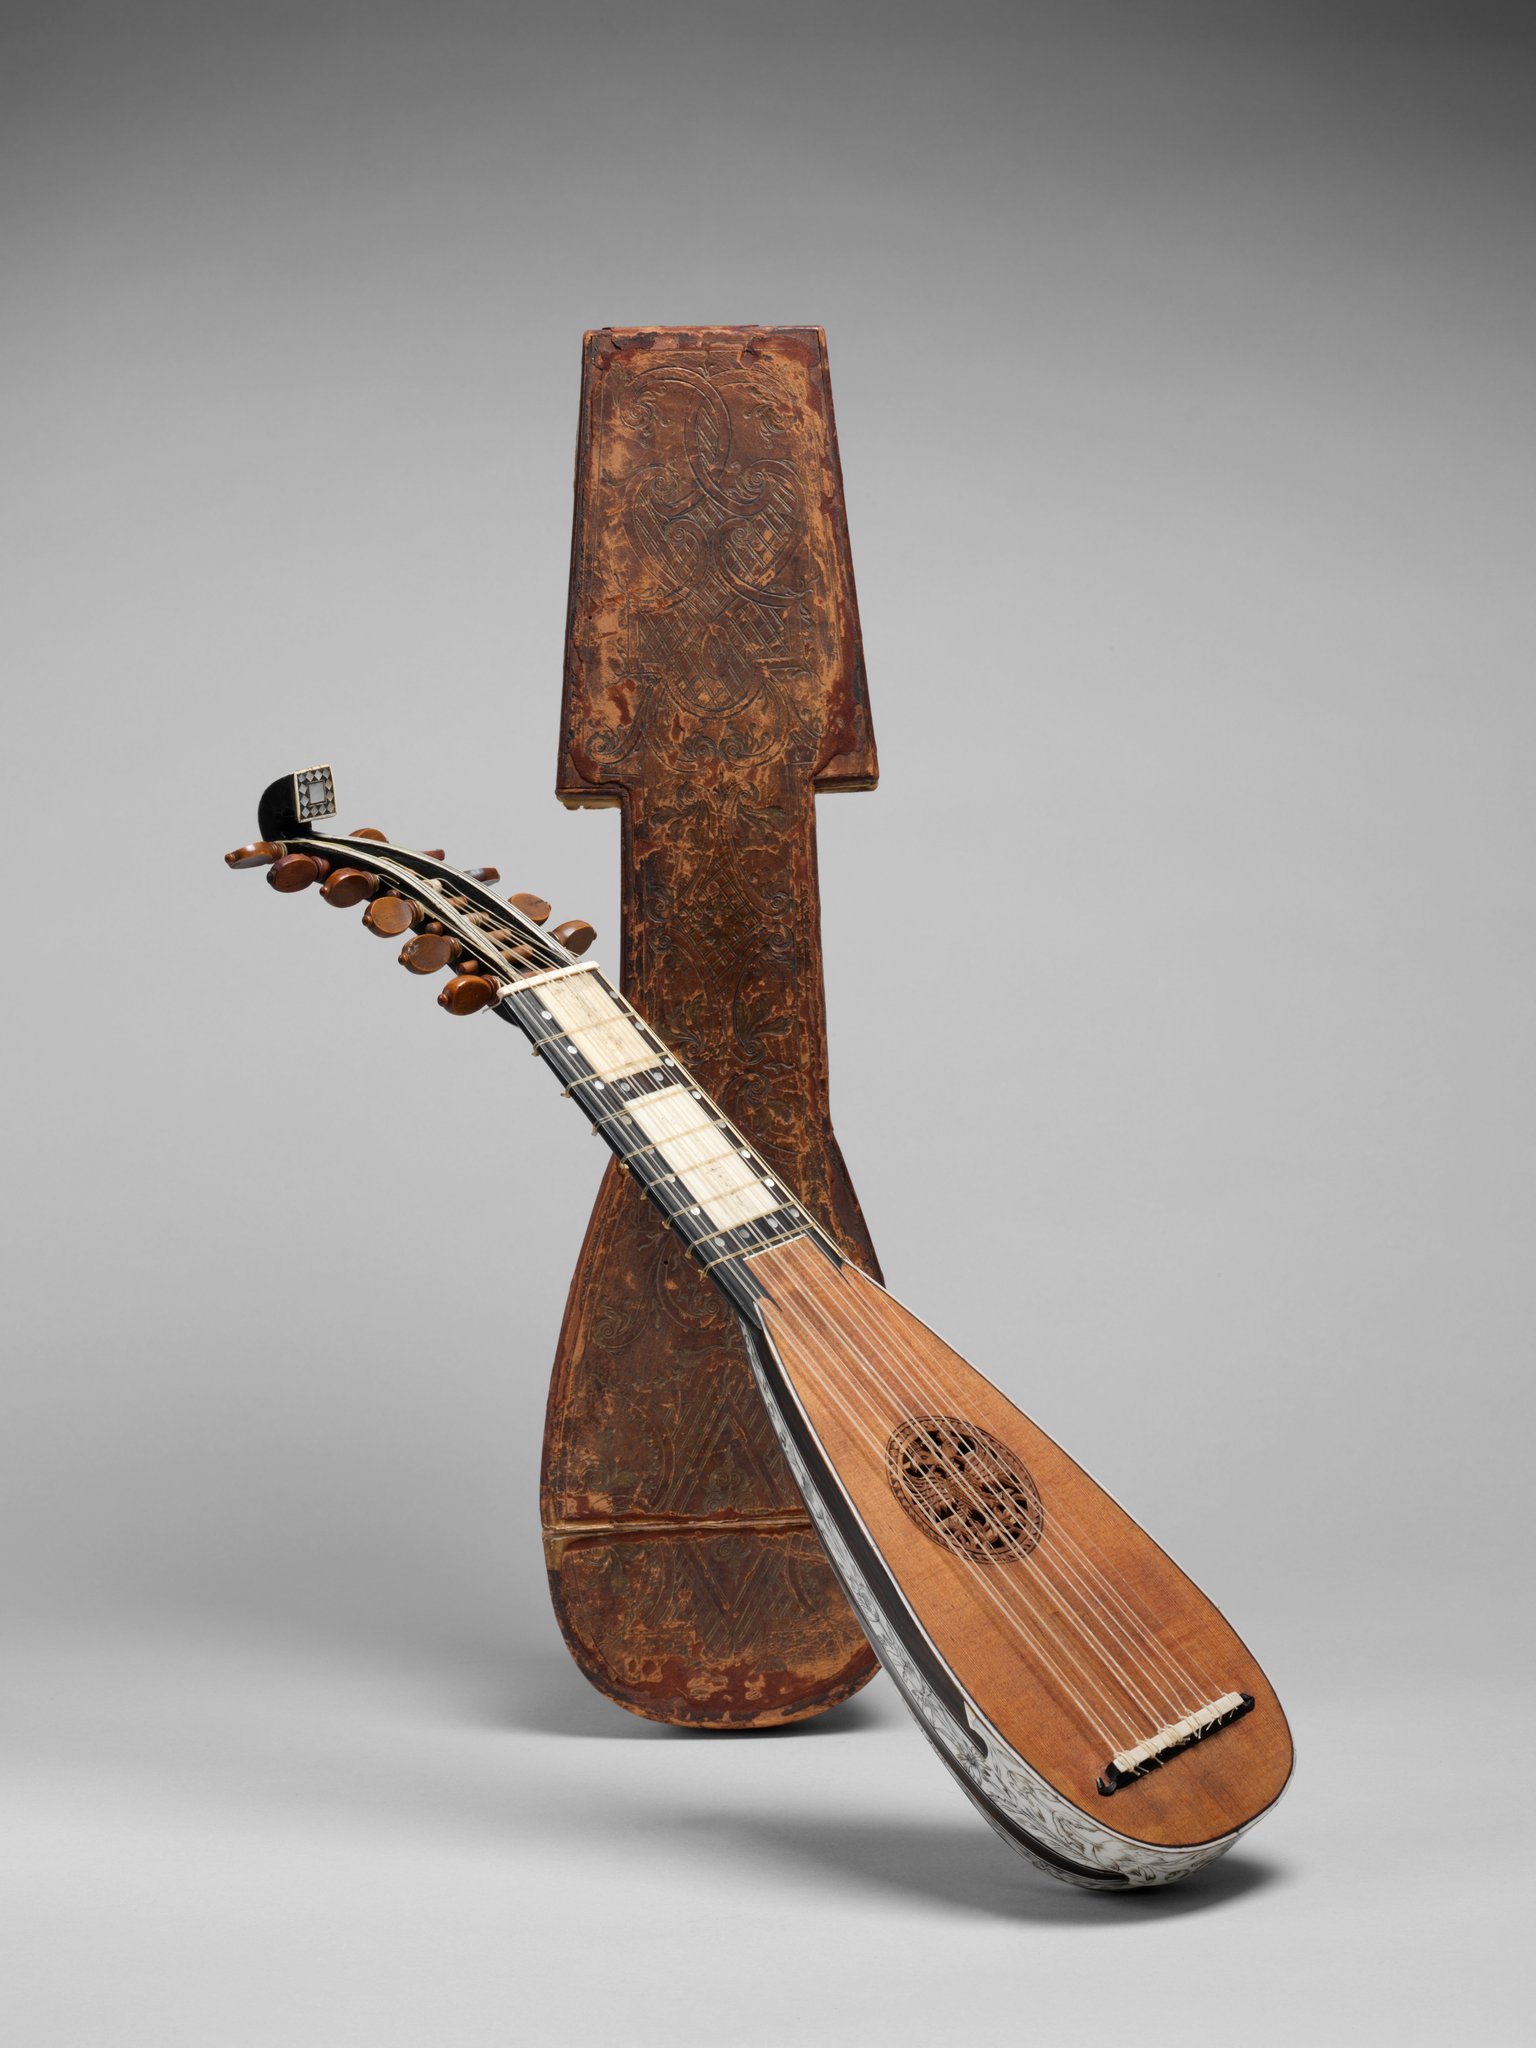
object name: mandolin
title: Mandolino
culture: italian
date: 1710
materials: wood, ivory, mother of pearl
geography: italy